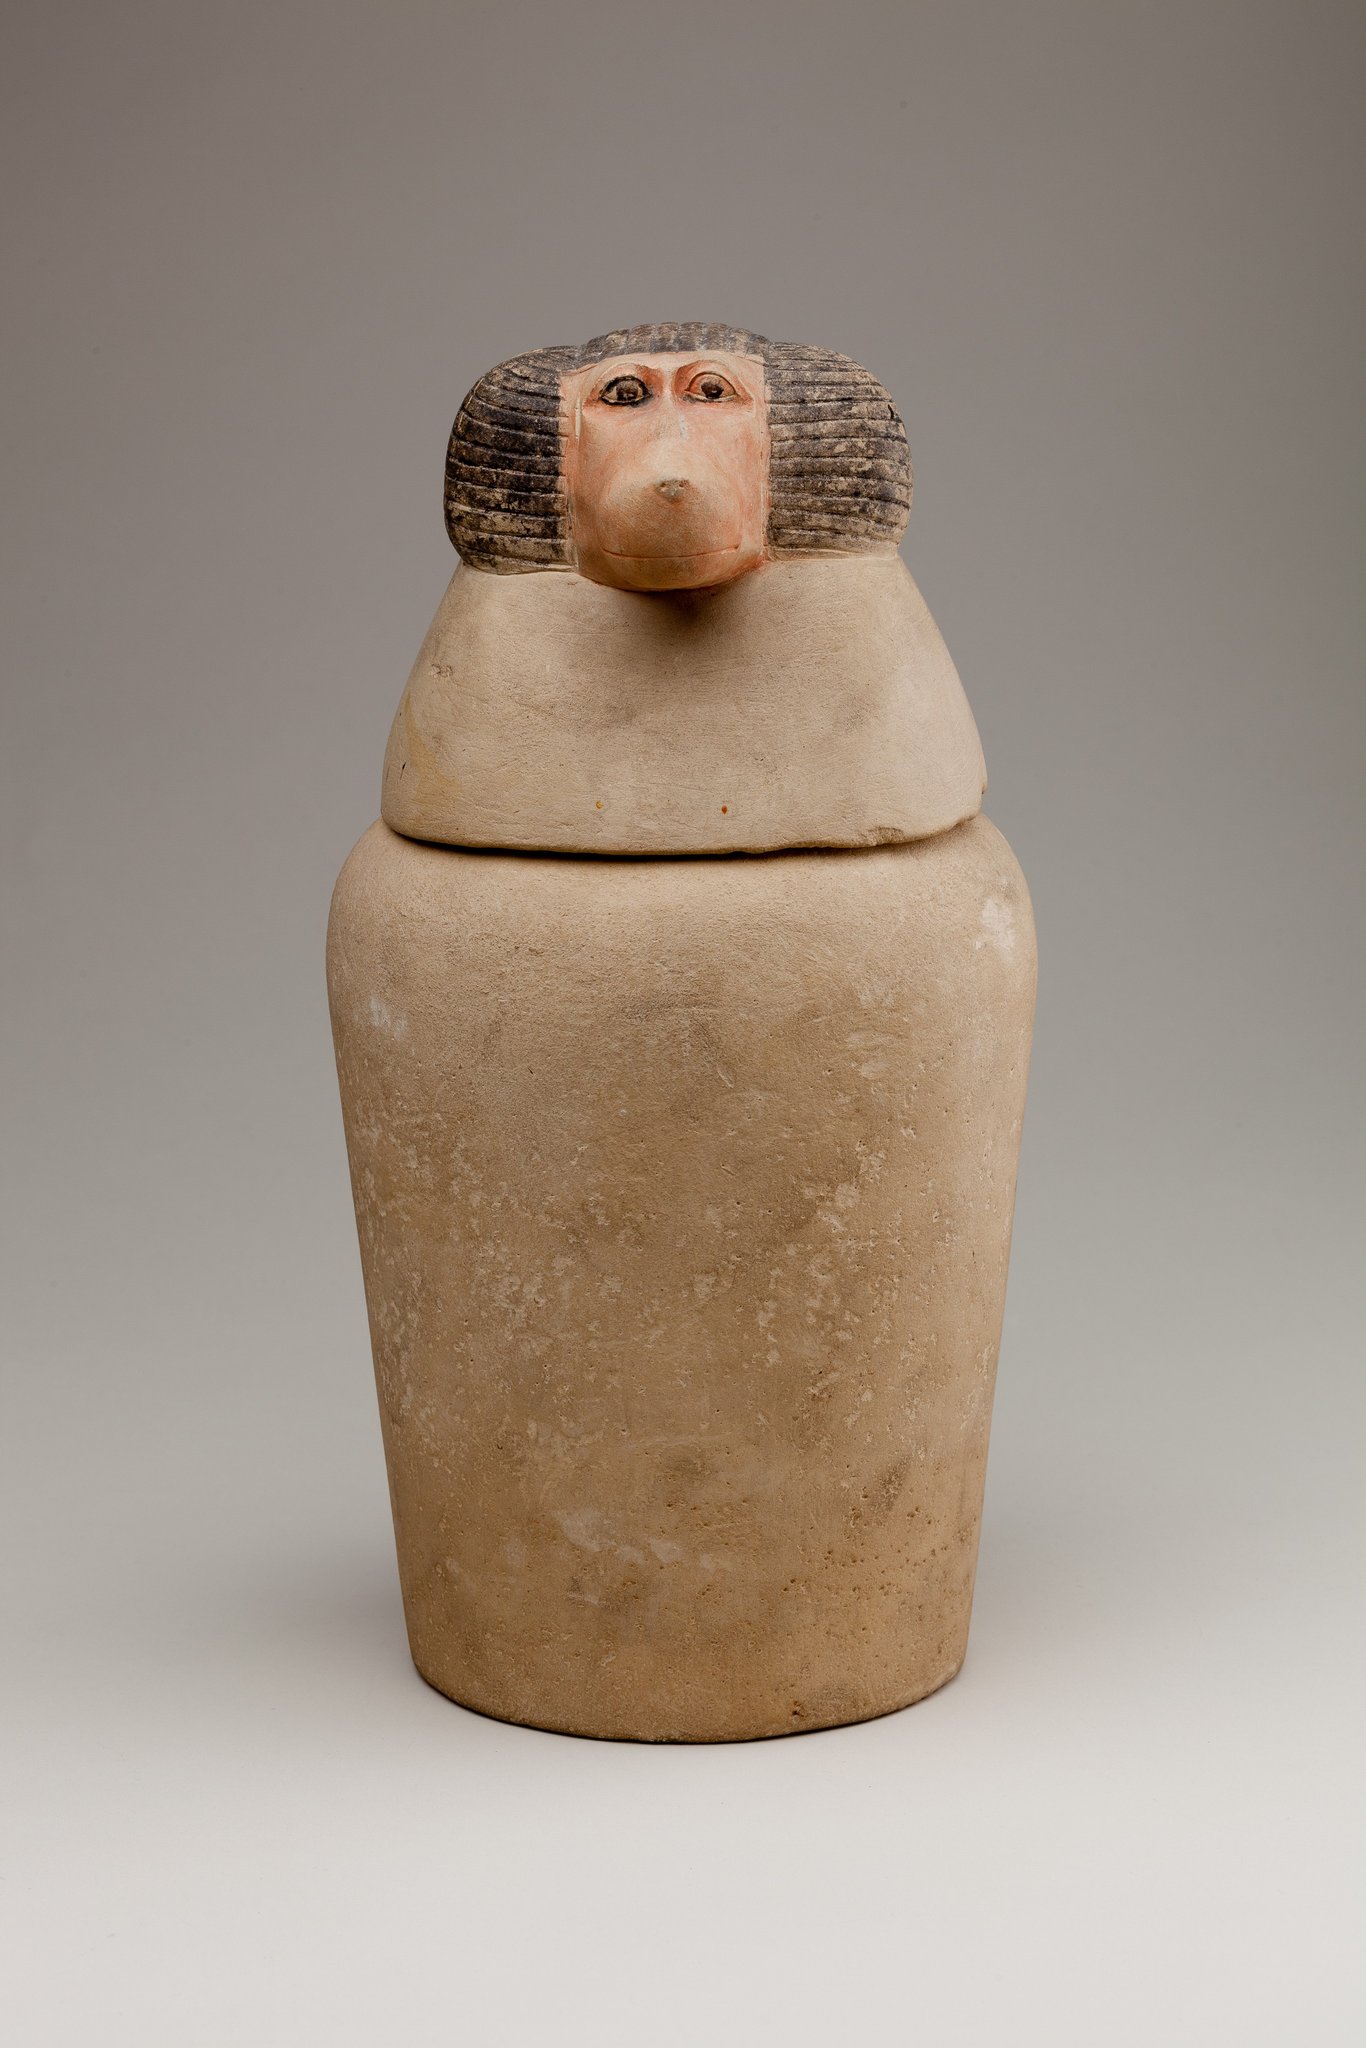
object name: canopic jar, baboon, hapy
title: Canopic Jar Representing the Deity Hapy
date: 664-525 BCE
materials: limestone, paint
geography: northern upper egypt